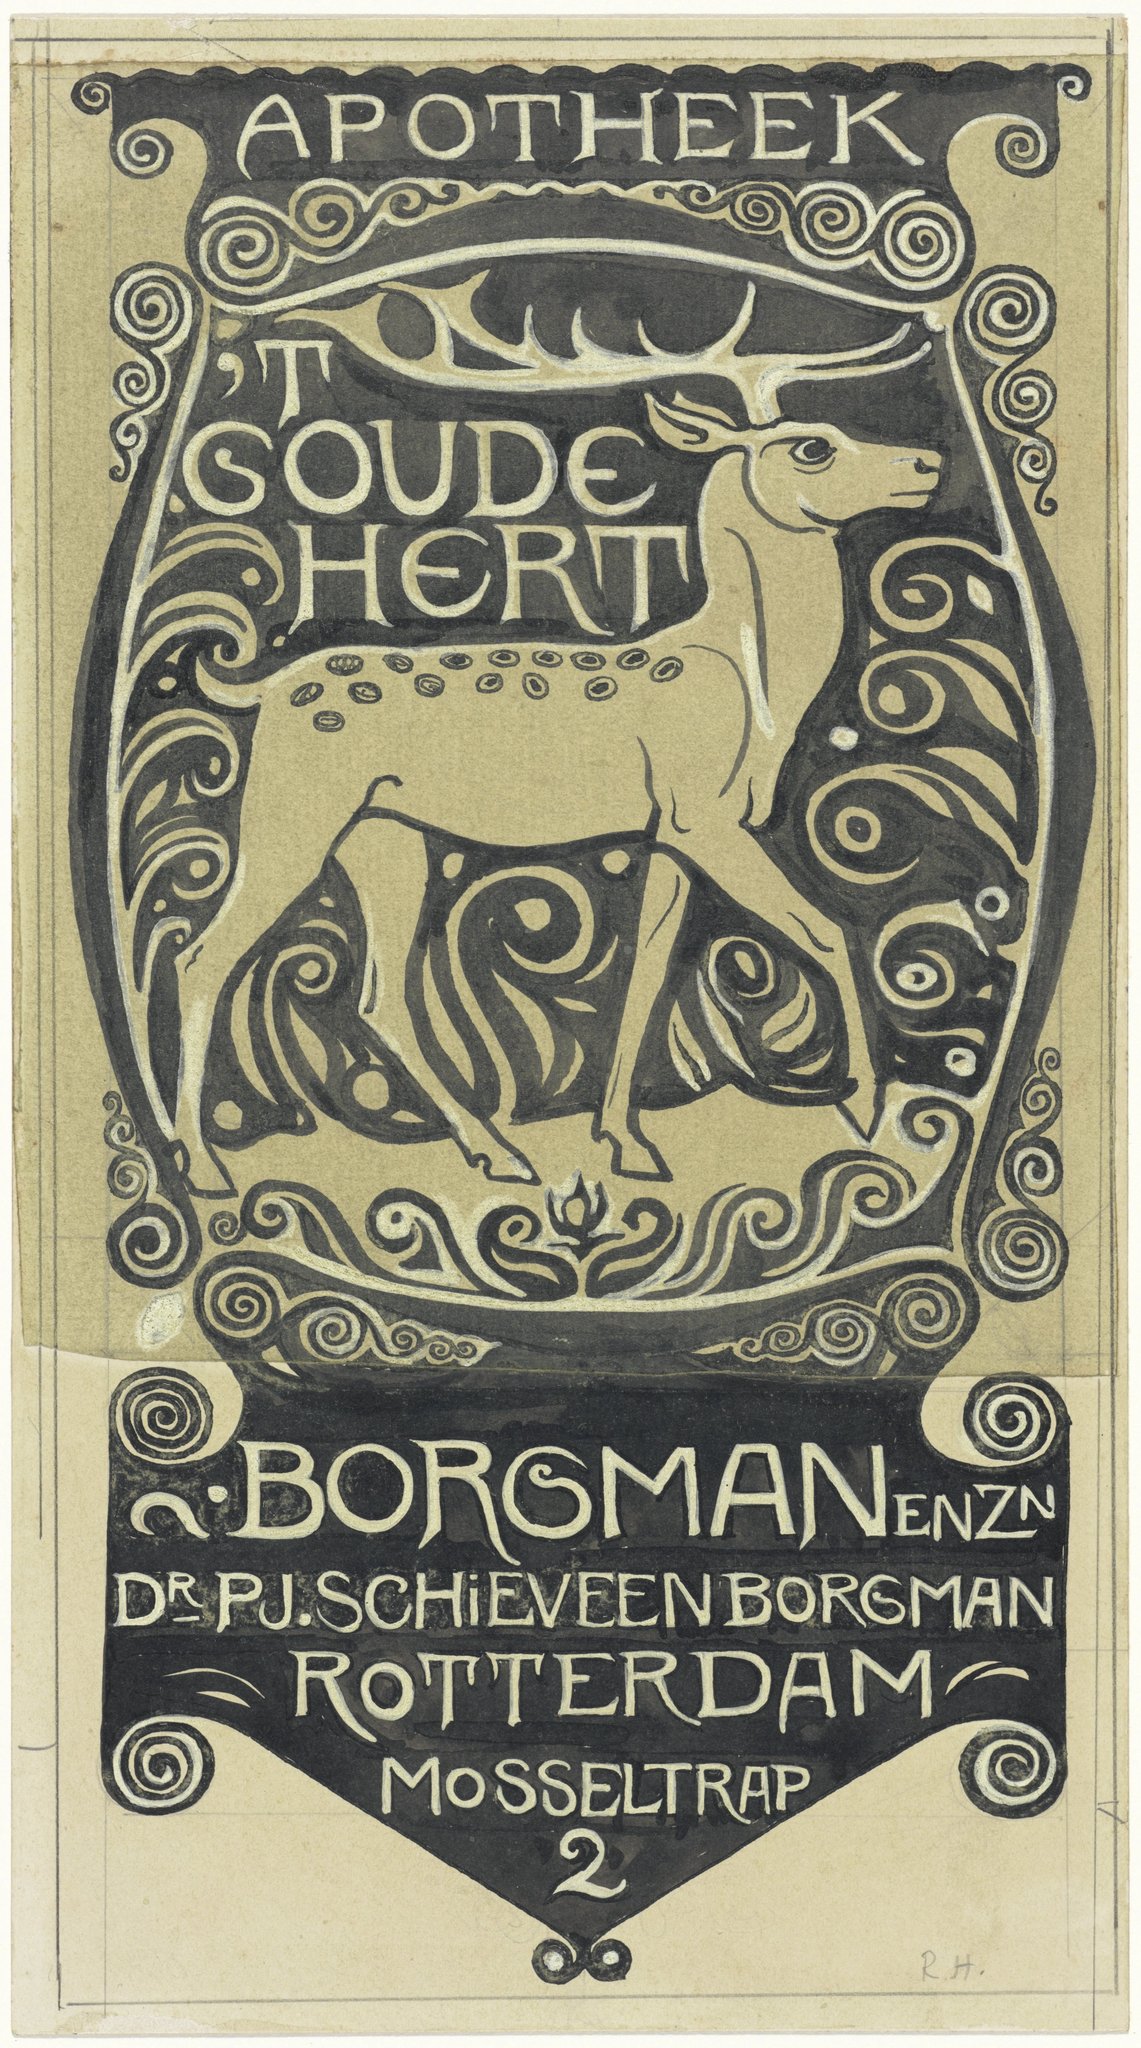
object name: drawing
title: Vignet Apotheek 't Goude Hert, Rotterdam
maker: richard nicolaüs roland holst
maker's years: 1868-1938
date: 1878-1938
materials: paper, pencil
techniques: brush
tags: hoofed animals: deer, names of organizations, companies, trade unions, etc., vignette